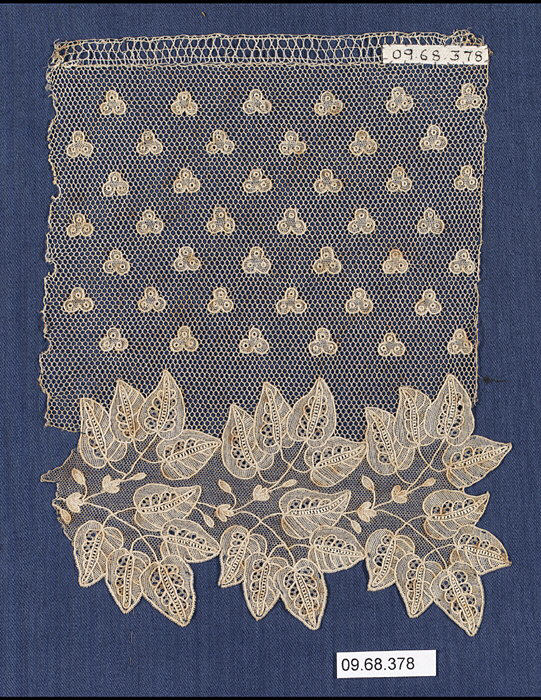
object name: fragment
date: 1801-1900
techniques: lace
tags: leaves